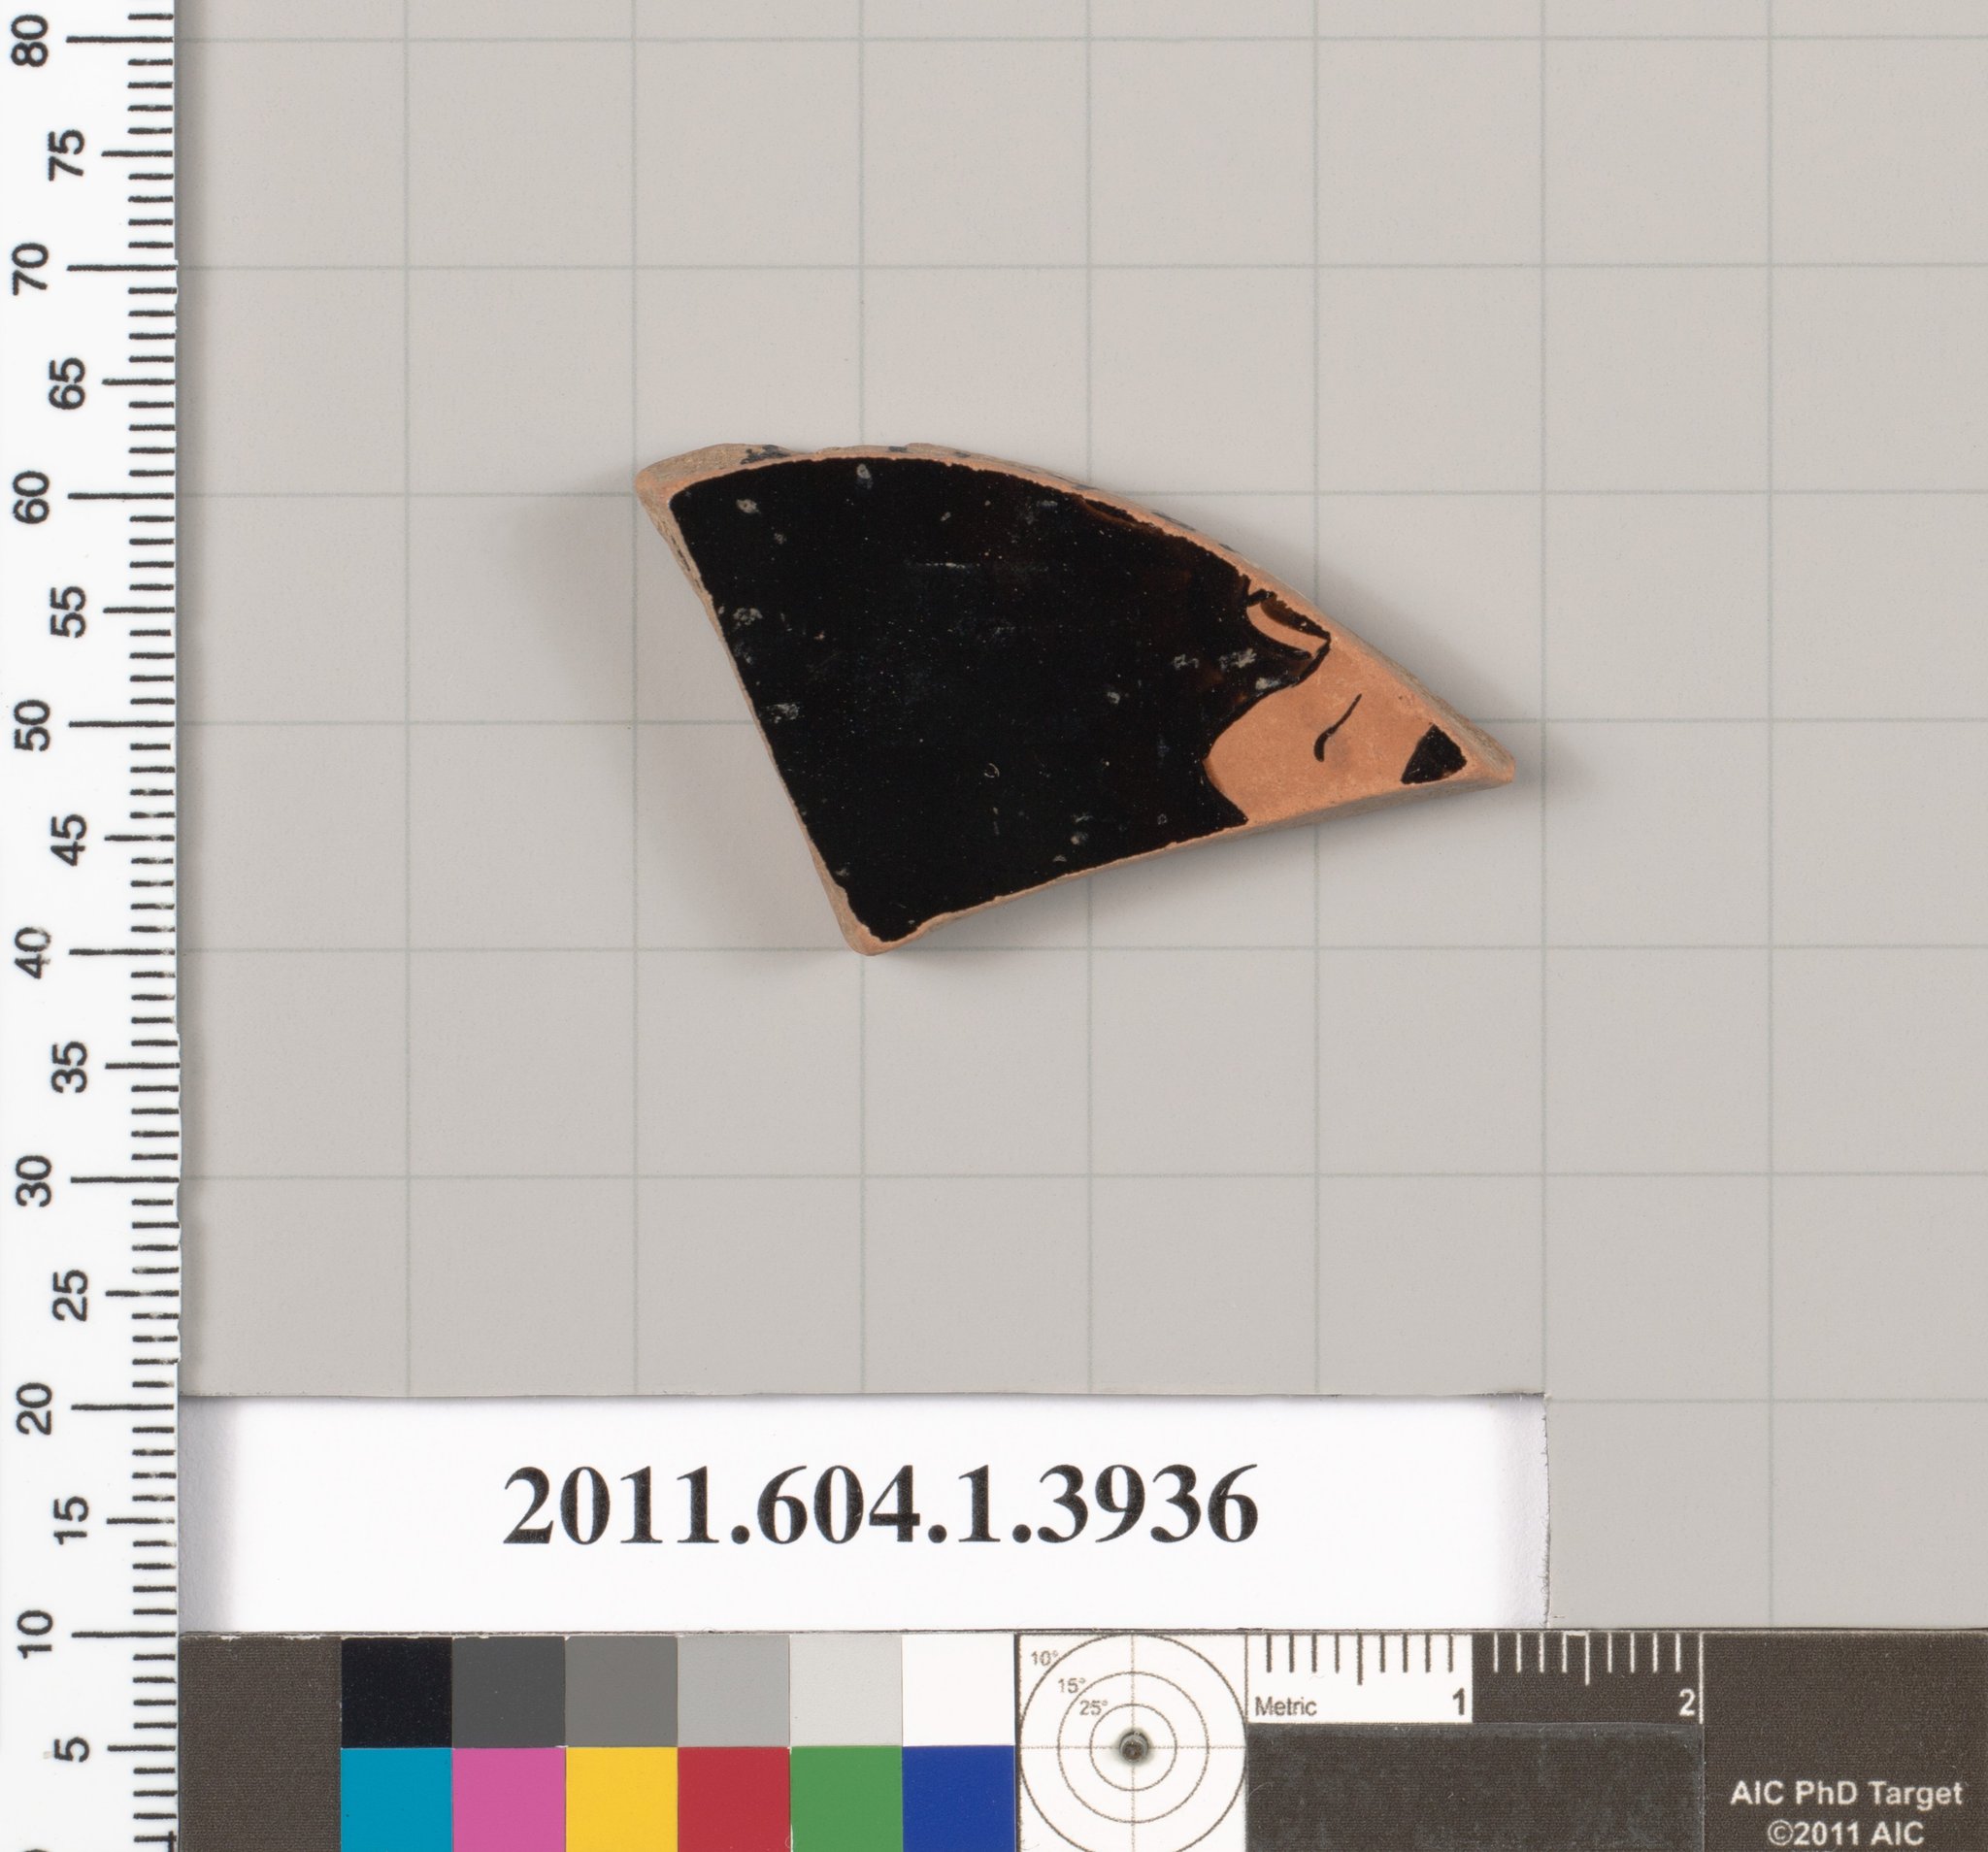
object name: kylix fragment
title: Terracotta fragment of a kylix (drinking cup)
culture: greek, attic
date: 500-480 BCE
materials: terracotta